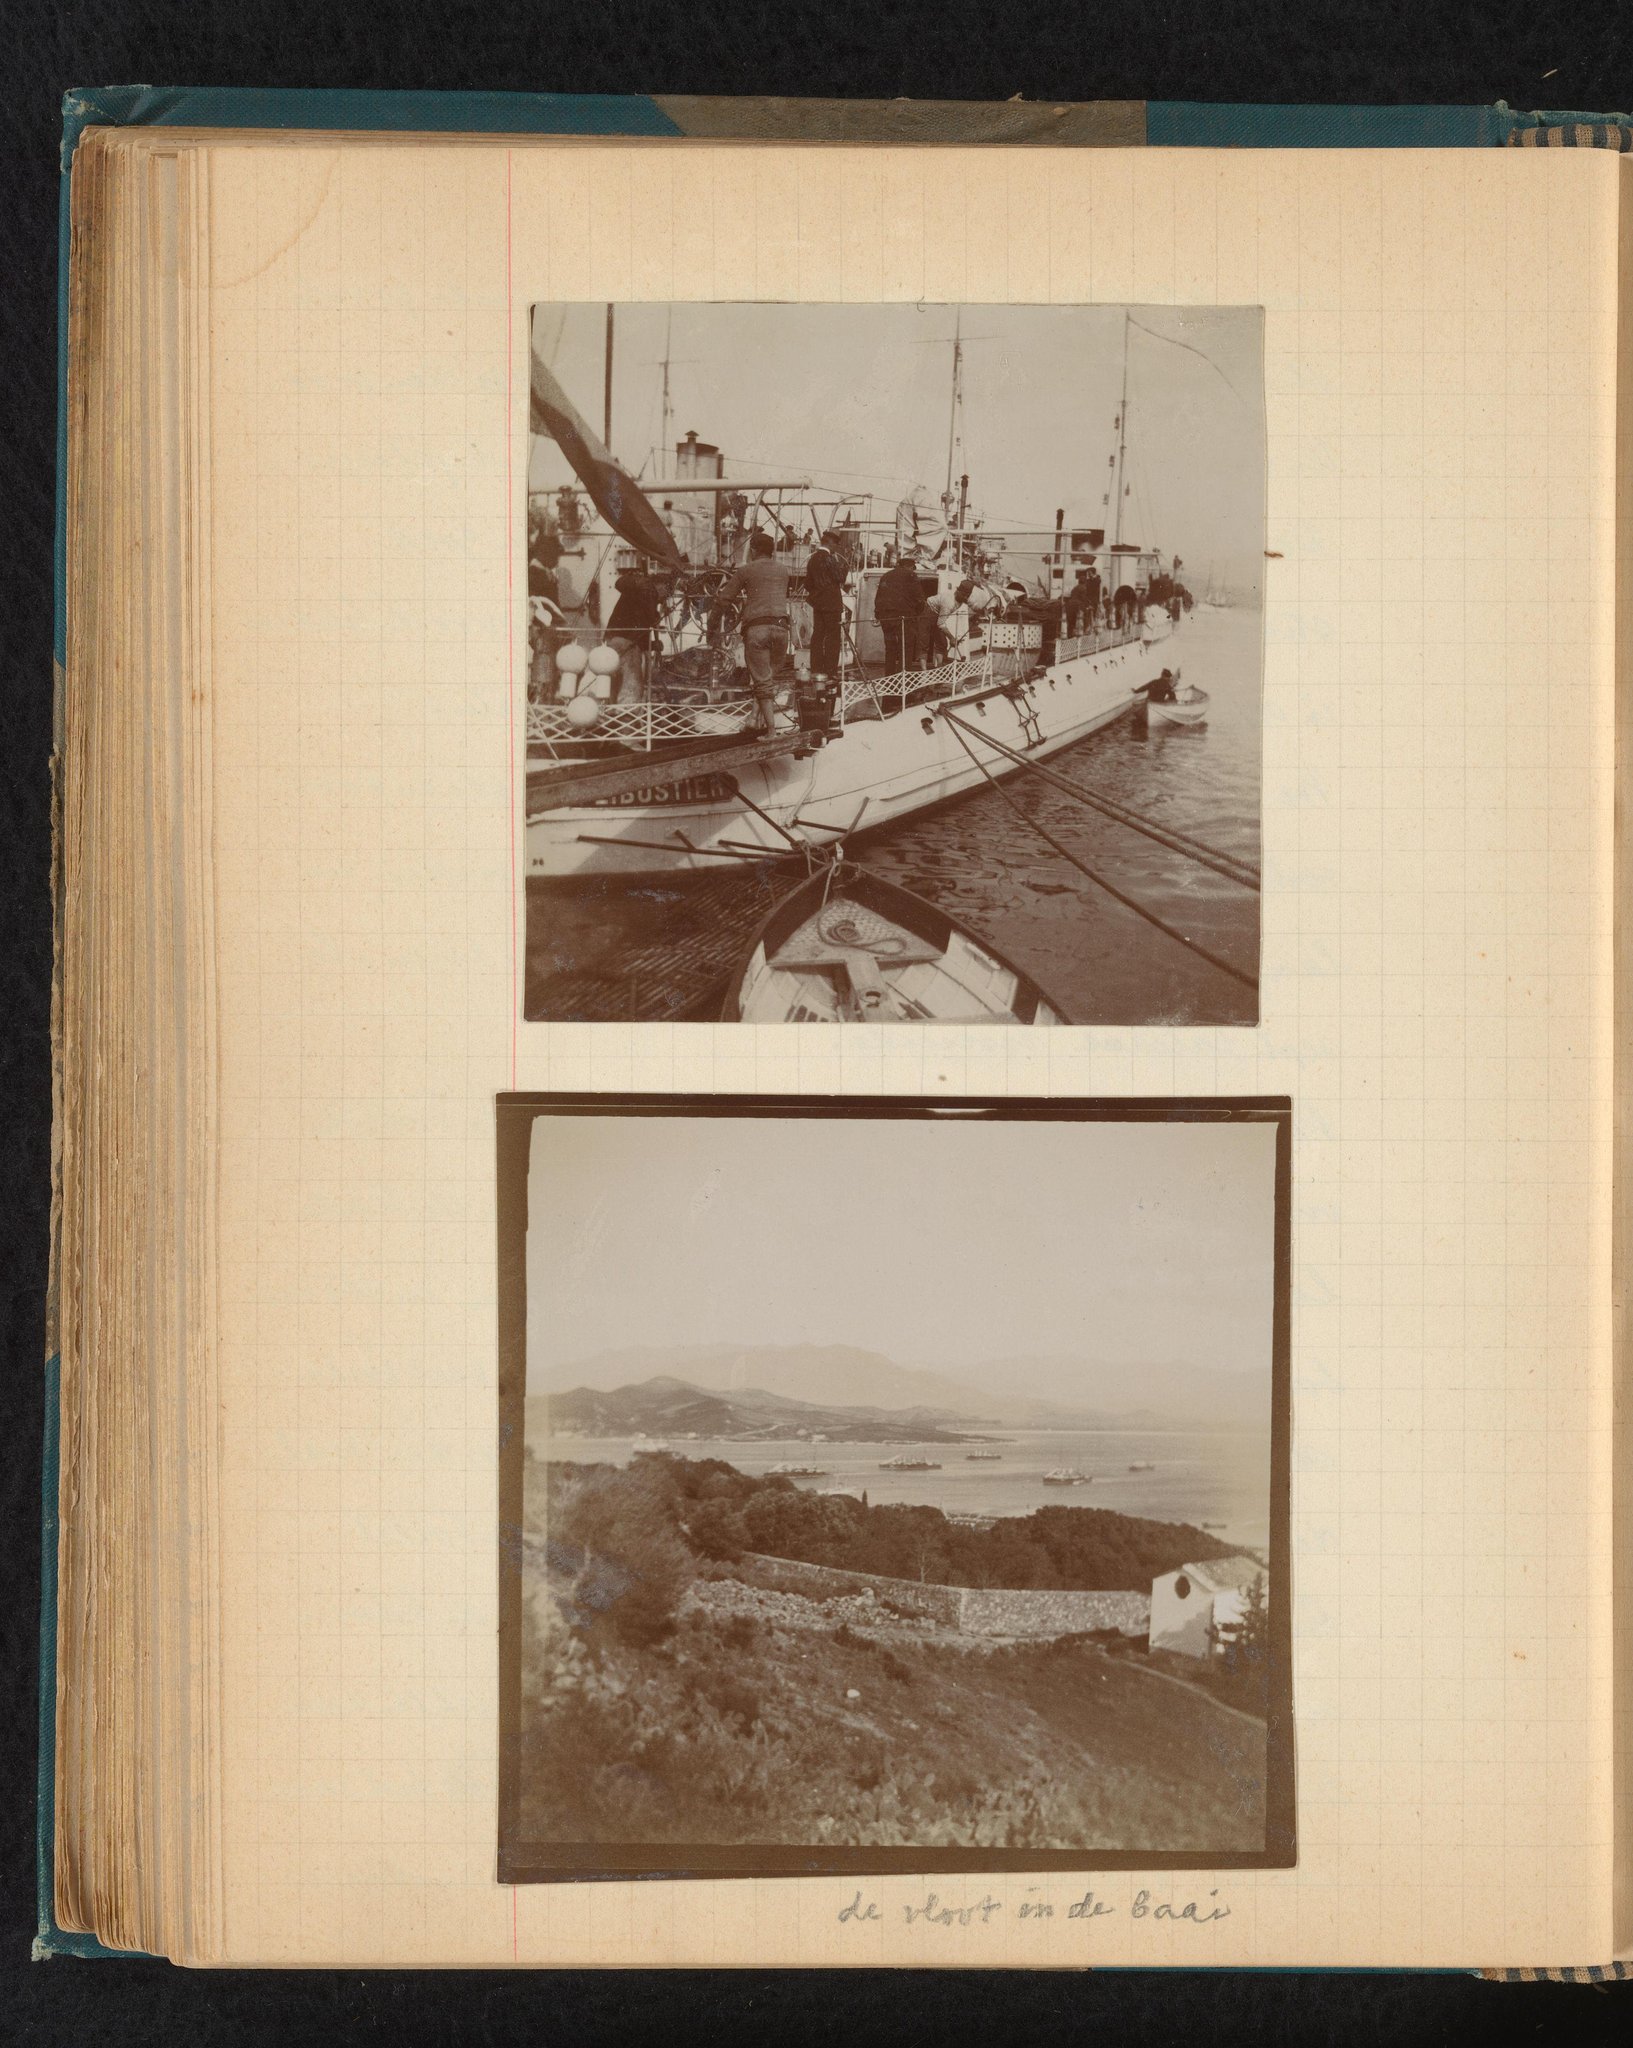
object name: album leaf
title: Schippers op een stoomboot en gezicht op een vloot in de baai van Ajaccio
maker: théodore van lelyveld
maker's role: painter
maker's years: 1867-1954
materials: paper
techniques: gelatin silver print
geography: ajaccio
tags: crew ~ ship, gulf, bay, steamship, motorship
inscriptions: inscription: ‘de vloot in de baai’